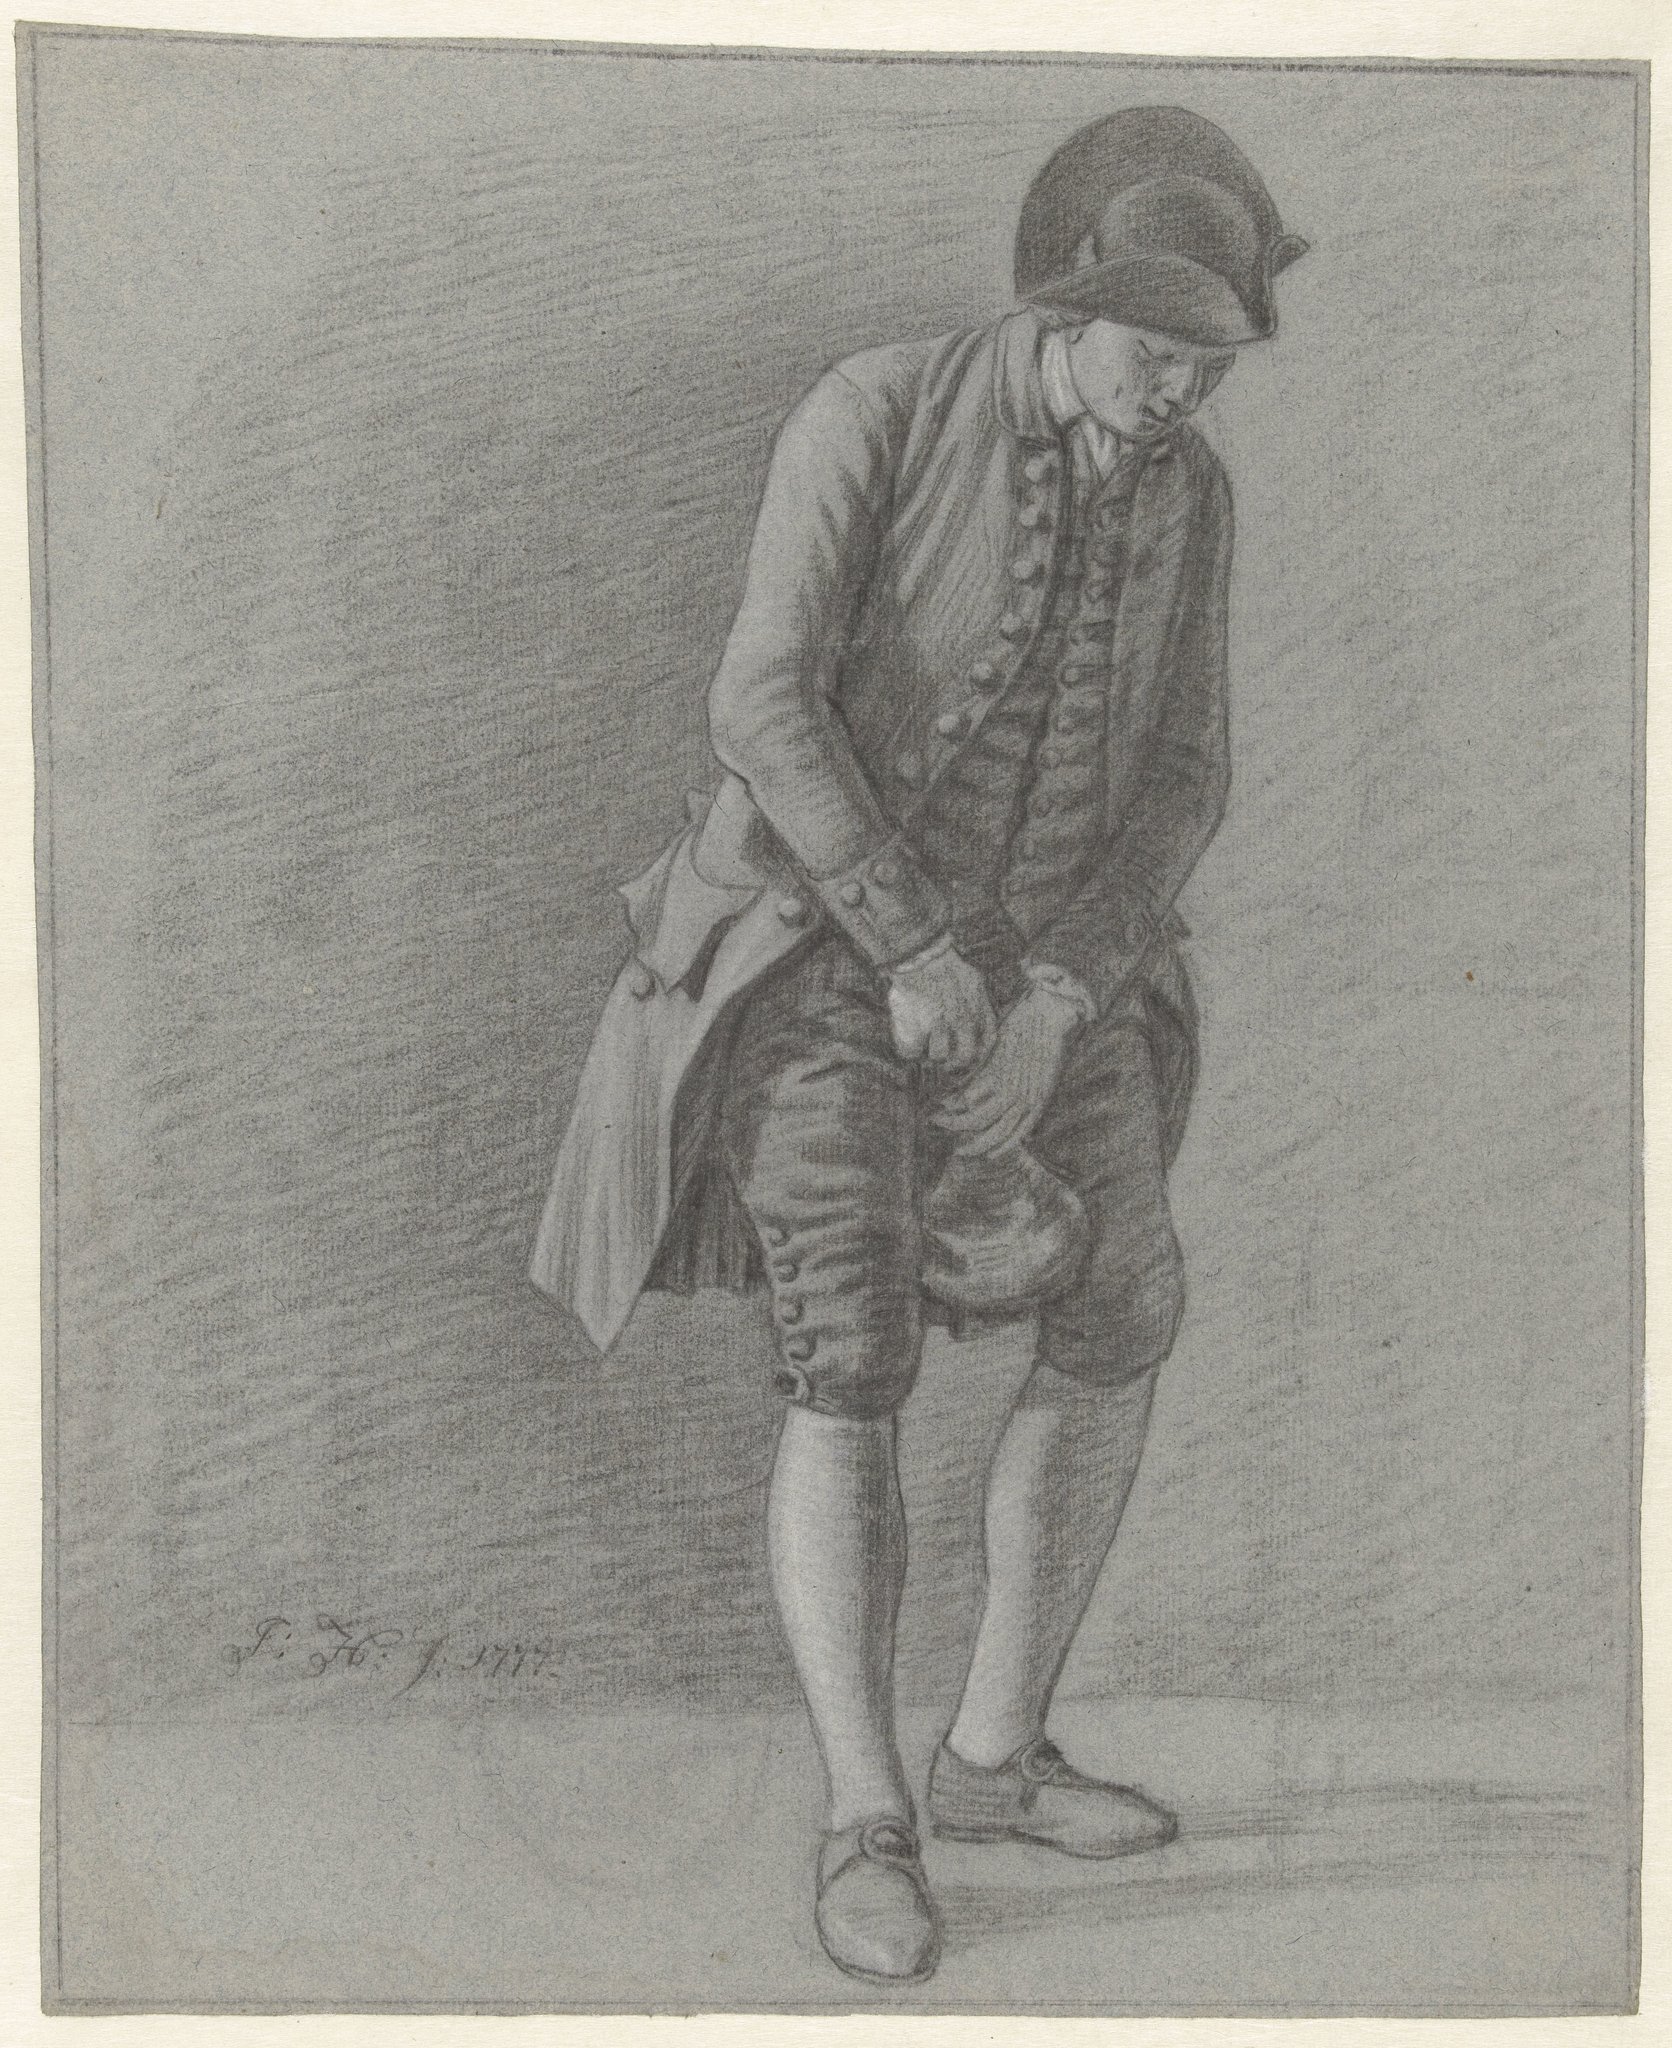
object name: drawing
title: Jonge man die de kurk uit een fles trekt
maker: jordanus hoorn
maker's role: draughtsman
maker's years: 1753-1833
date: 1777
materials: chalk, paper